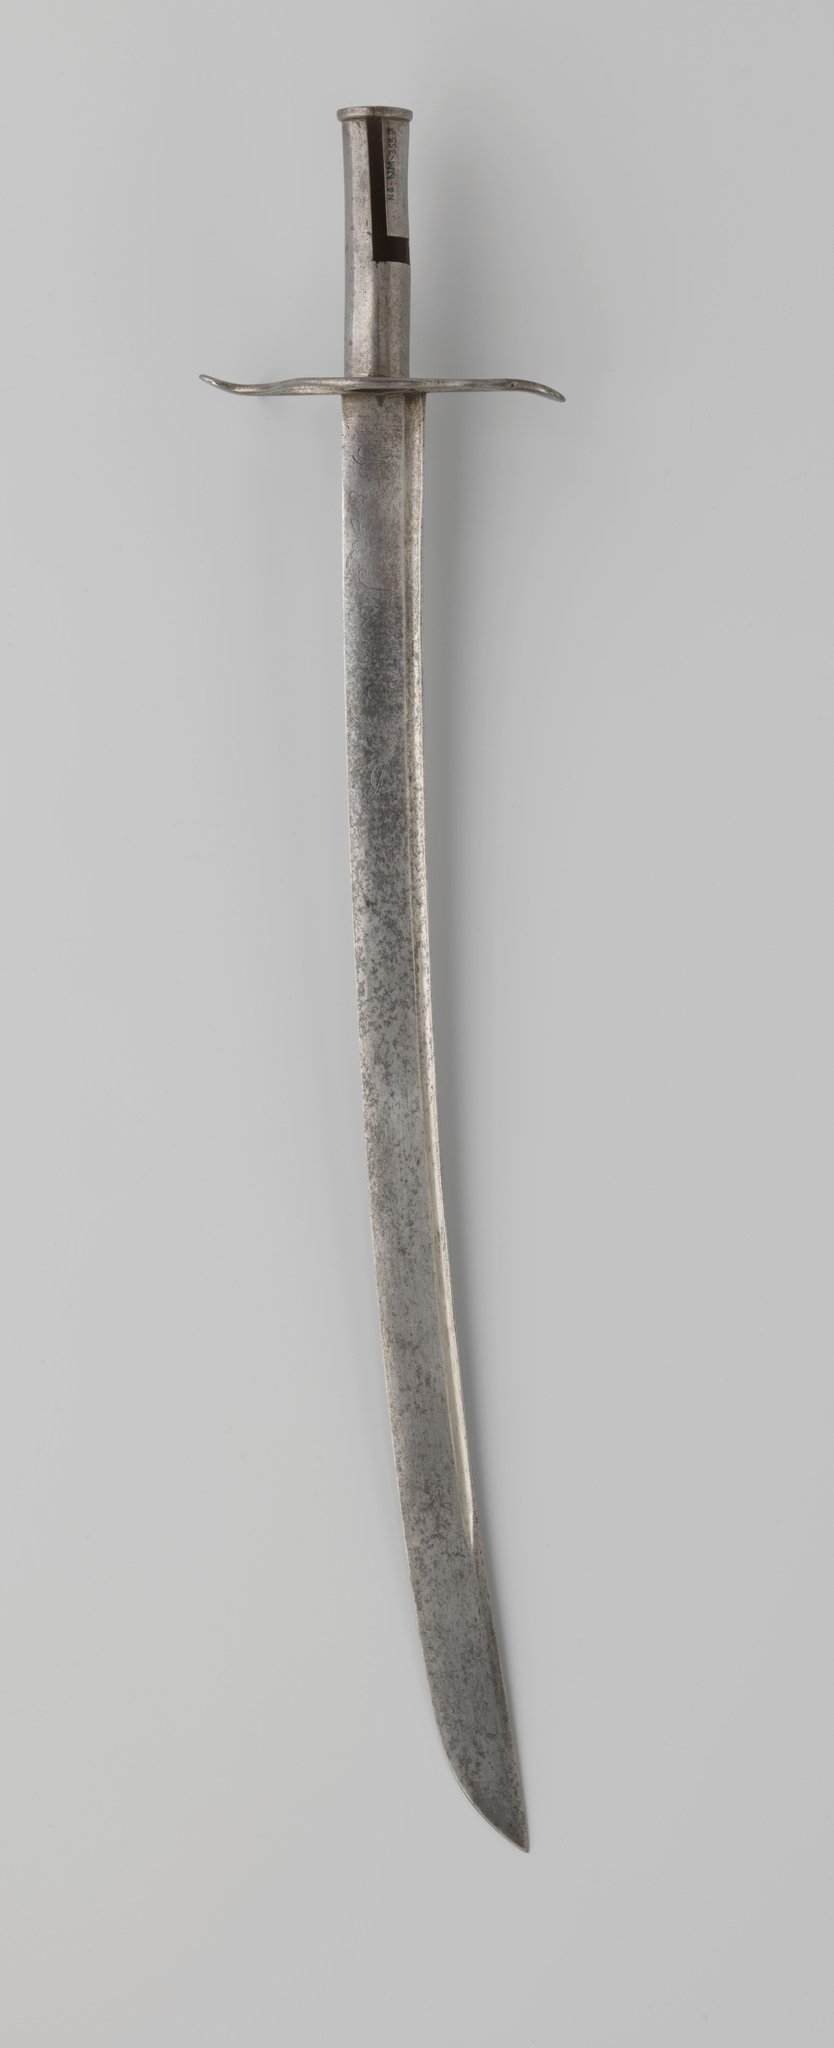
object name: sword bayonet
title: Sabelbajonet van de marine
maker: Anonymous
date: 1700-1900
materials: iron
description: Bajonetsabel van de marine; waarop (de inscriptie?) 'Marine'.